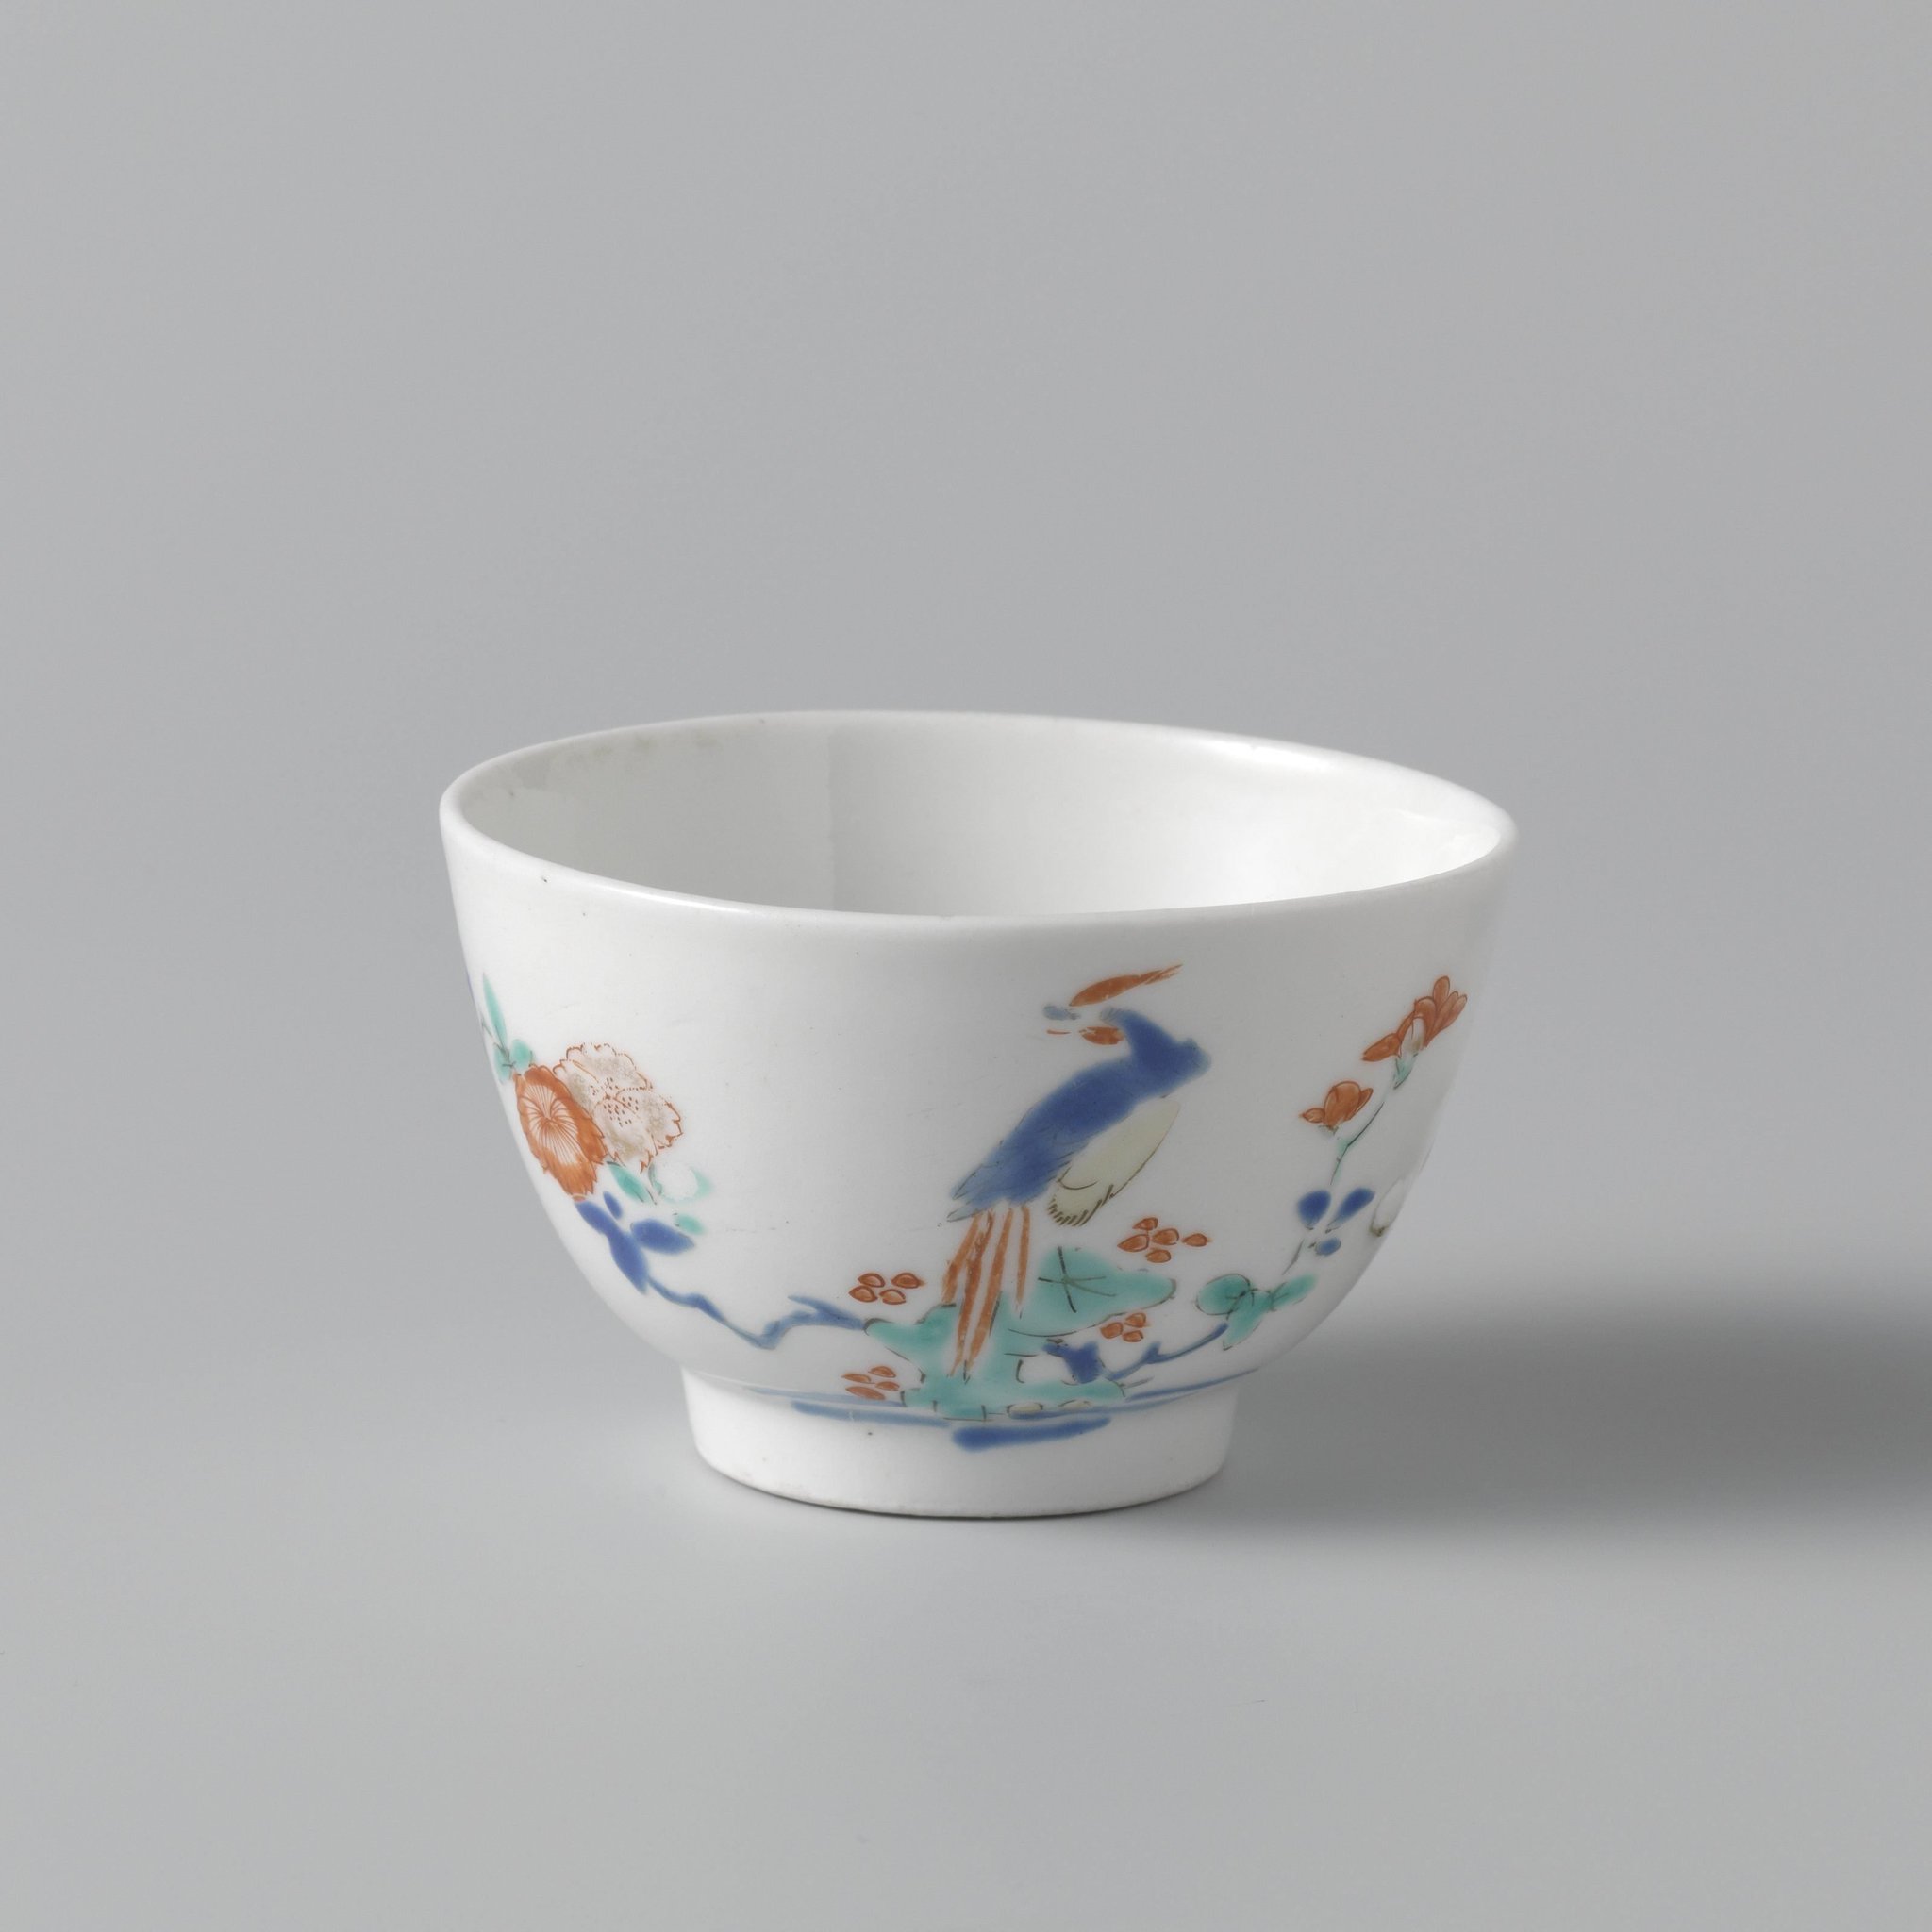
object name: cup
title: Cup with hoo birds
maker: Anonymous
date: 1670-1700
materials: glaze, gold, paint, porcelain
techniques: firing, gilding, turning, vitrification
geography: japan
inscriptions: label: ‘Collectie Westendorp/ 38’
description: Ronde kop van porselein, beschilderd op het glazuur in blauw, rood, groen, geel, zwart en goud met een een paar hoo-vogels, een in de lucht en een op een rots met een bloemtak. Binnen op de bodem een rozet binnen een dubbele cirkel in rood en goud. 'Collectie Westendorp/ 38'. Kakiemon-stijl.